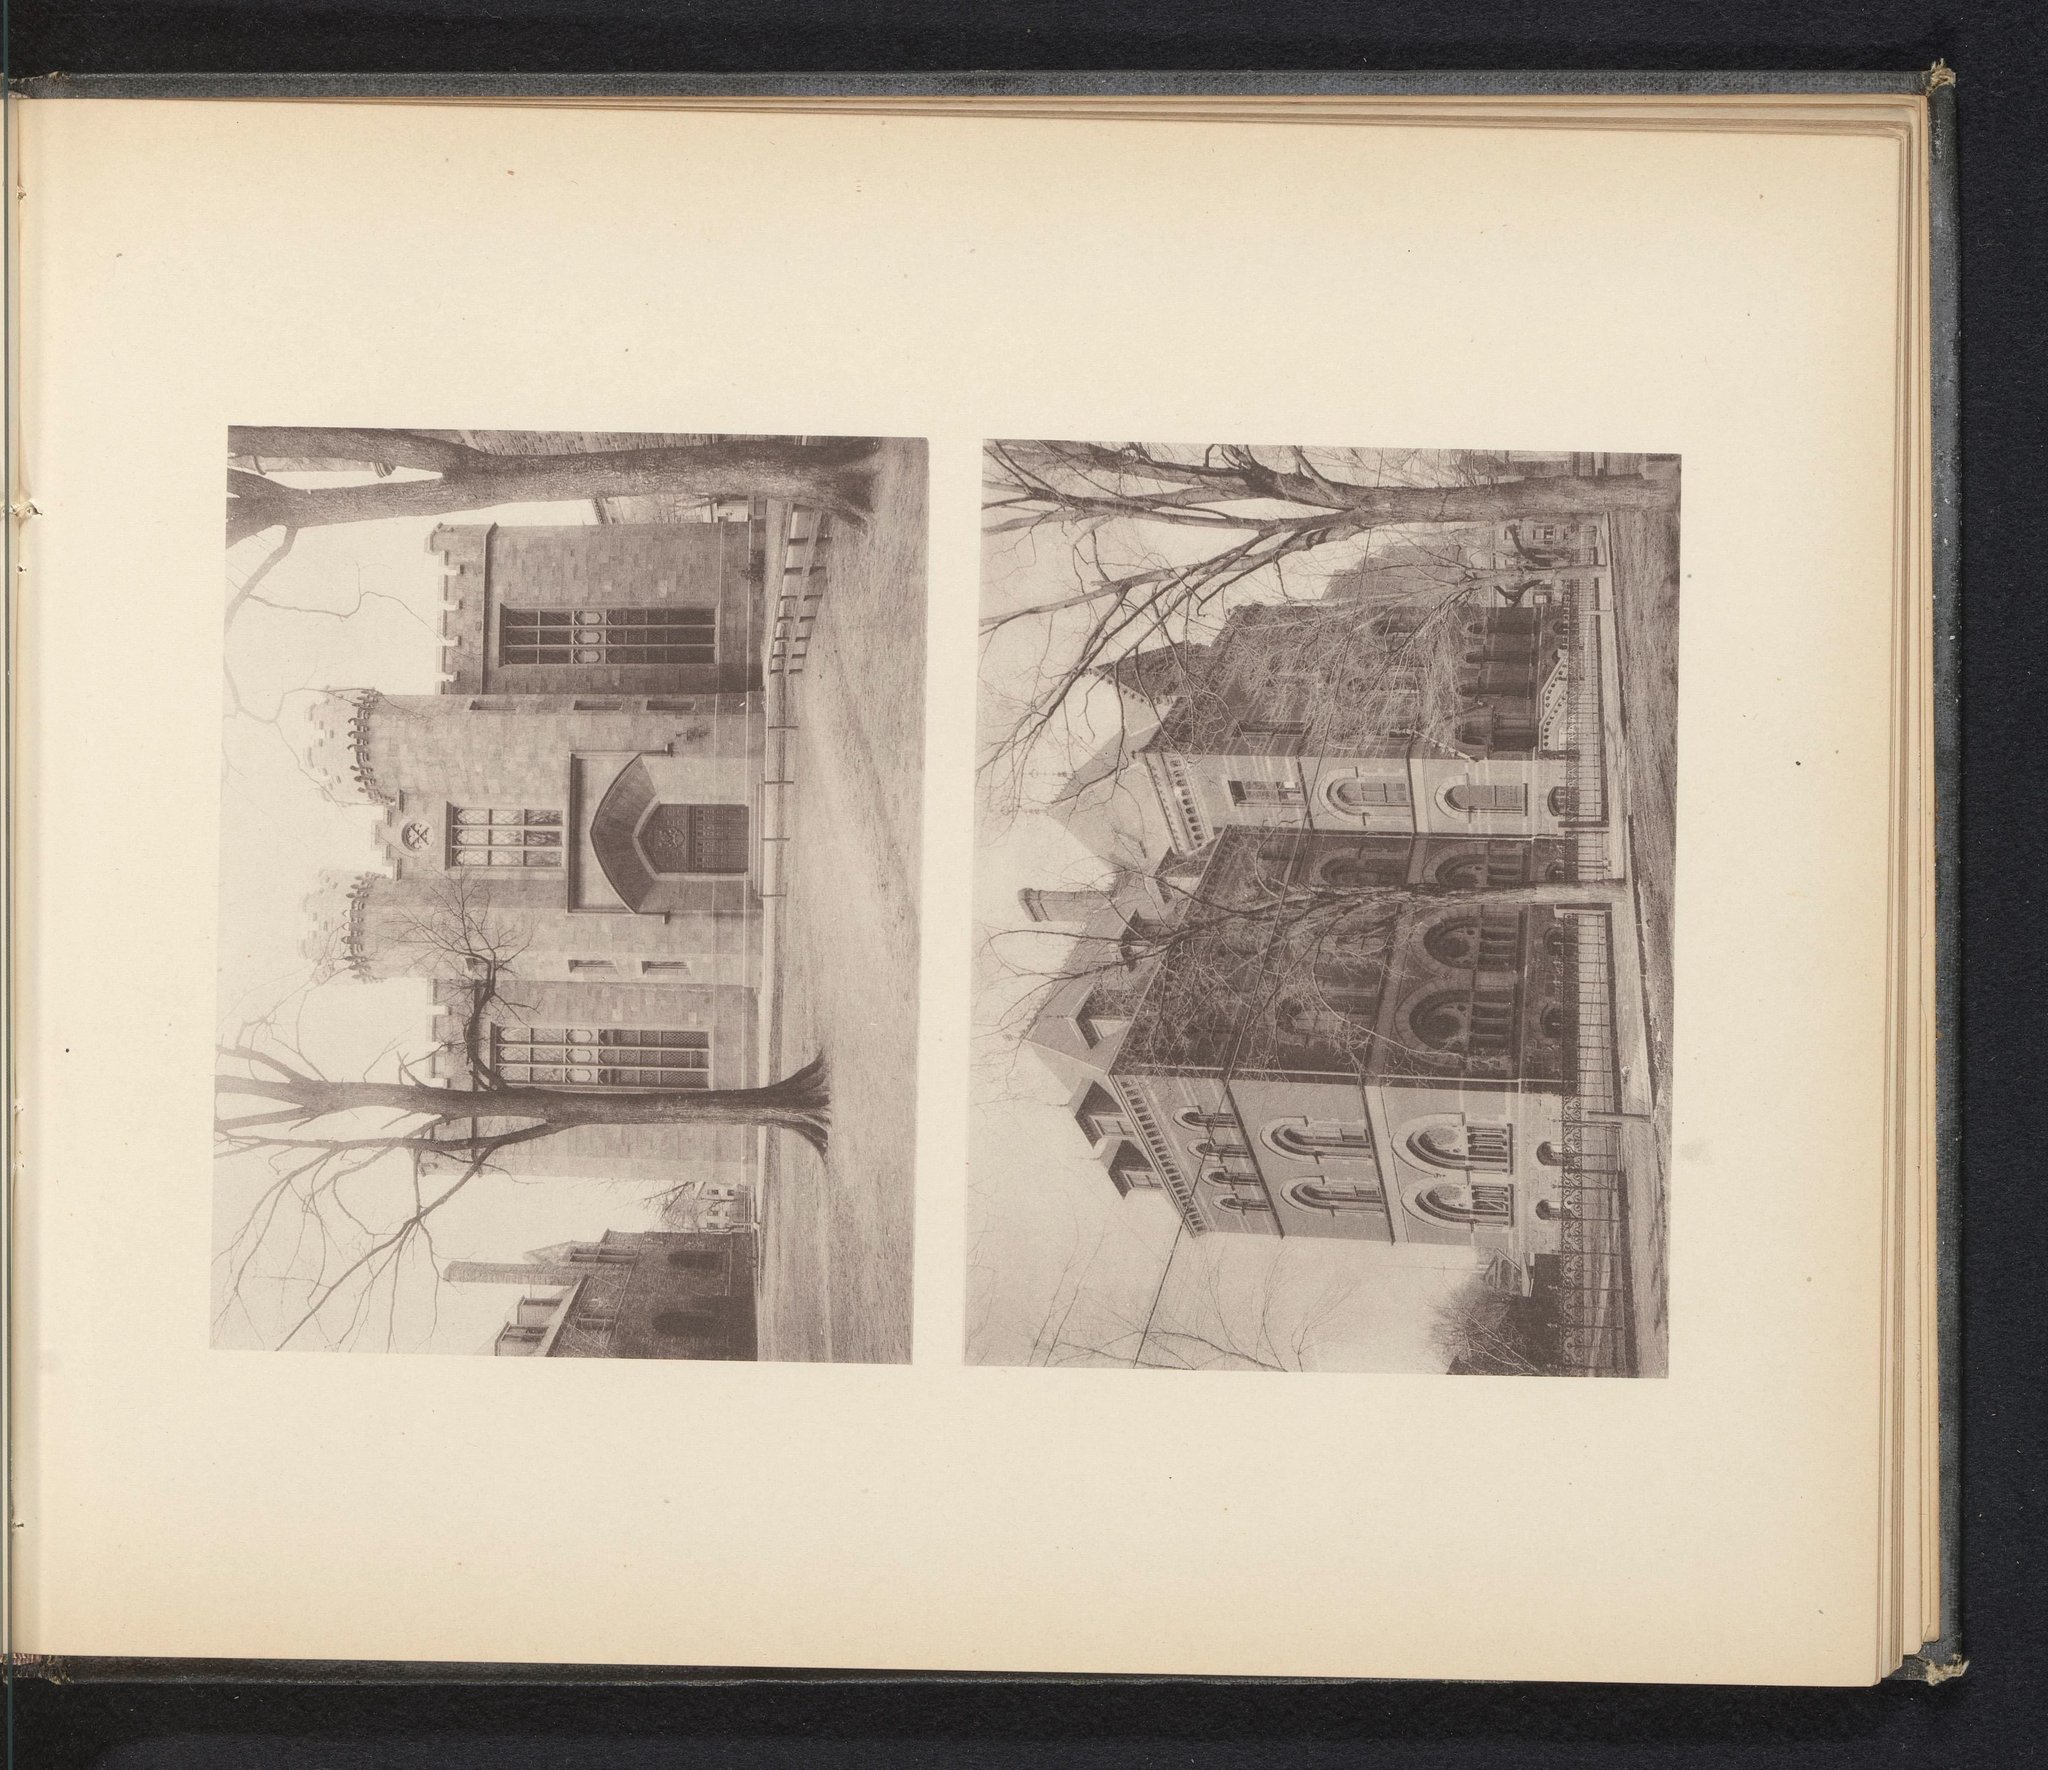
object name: photomechanical print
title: Twee exterieurs van Alumni Hall en het Peabody Museum of Natural History van Yale University te New Haven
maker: Anonymous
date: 1890-1895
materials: paper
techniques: photograph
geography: new york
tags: permanent exhibition, museum, university building, college, façade (of house or building)